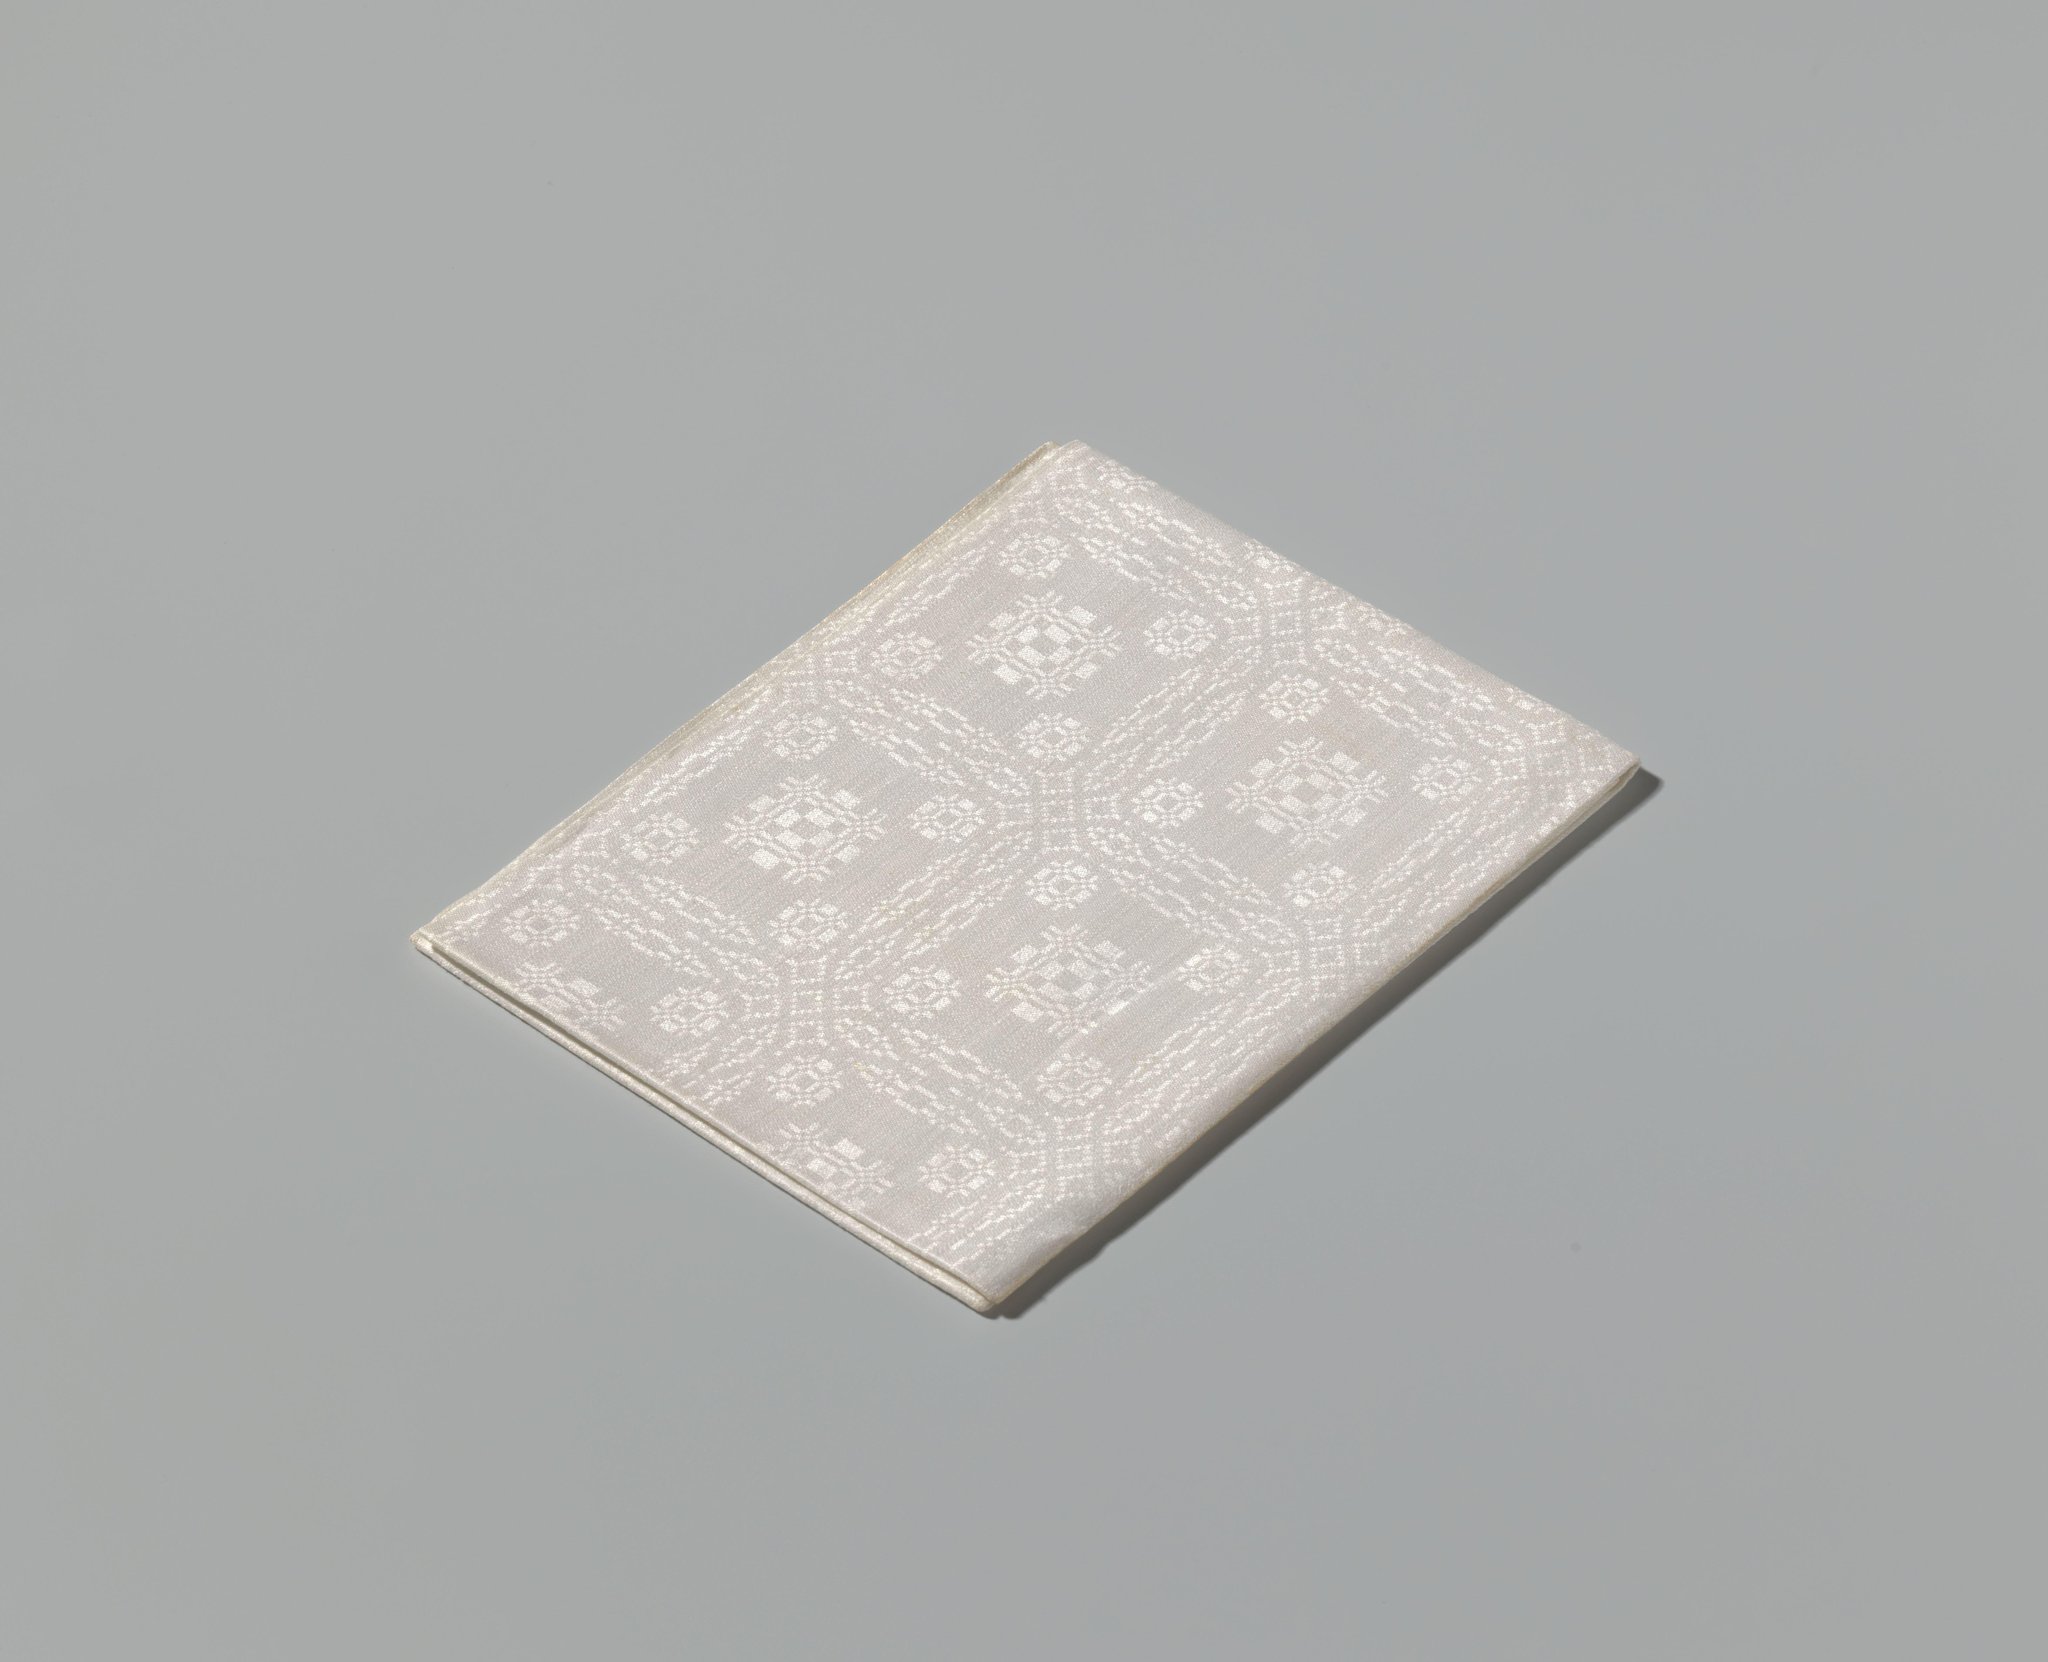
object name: napkin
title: Servet van linnen met pellenpatroon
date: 1690-1710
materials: linen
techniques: peeled fabric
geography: northern netherlands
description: wit linnen servet met pellen patroon, merk kroon G 36